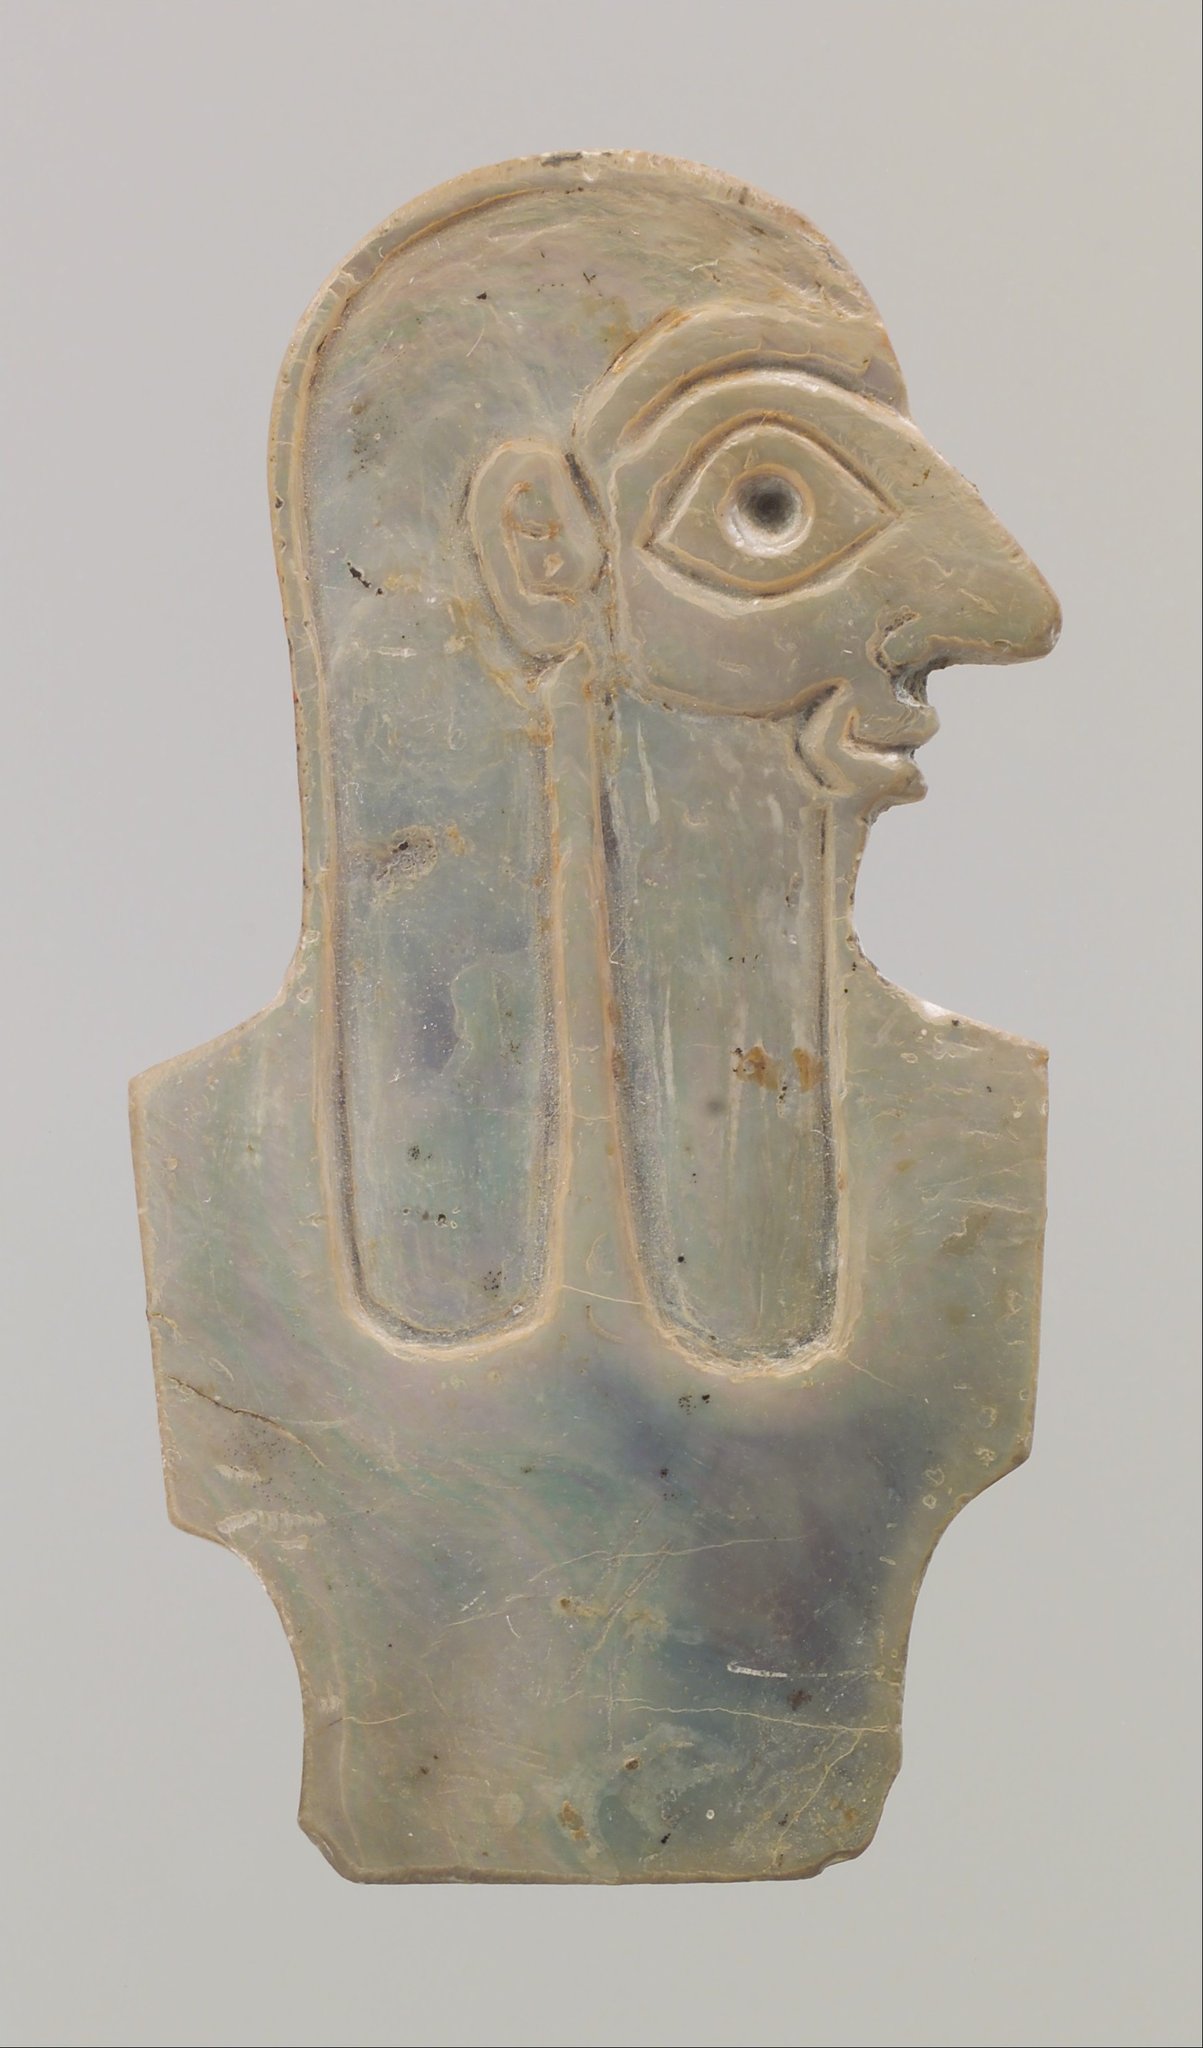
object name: inlay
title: Inlay depicting male torso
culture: sumerian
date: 2600-2500 BCE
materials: shell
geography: mesopotamia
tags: men